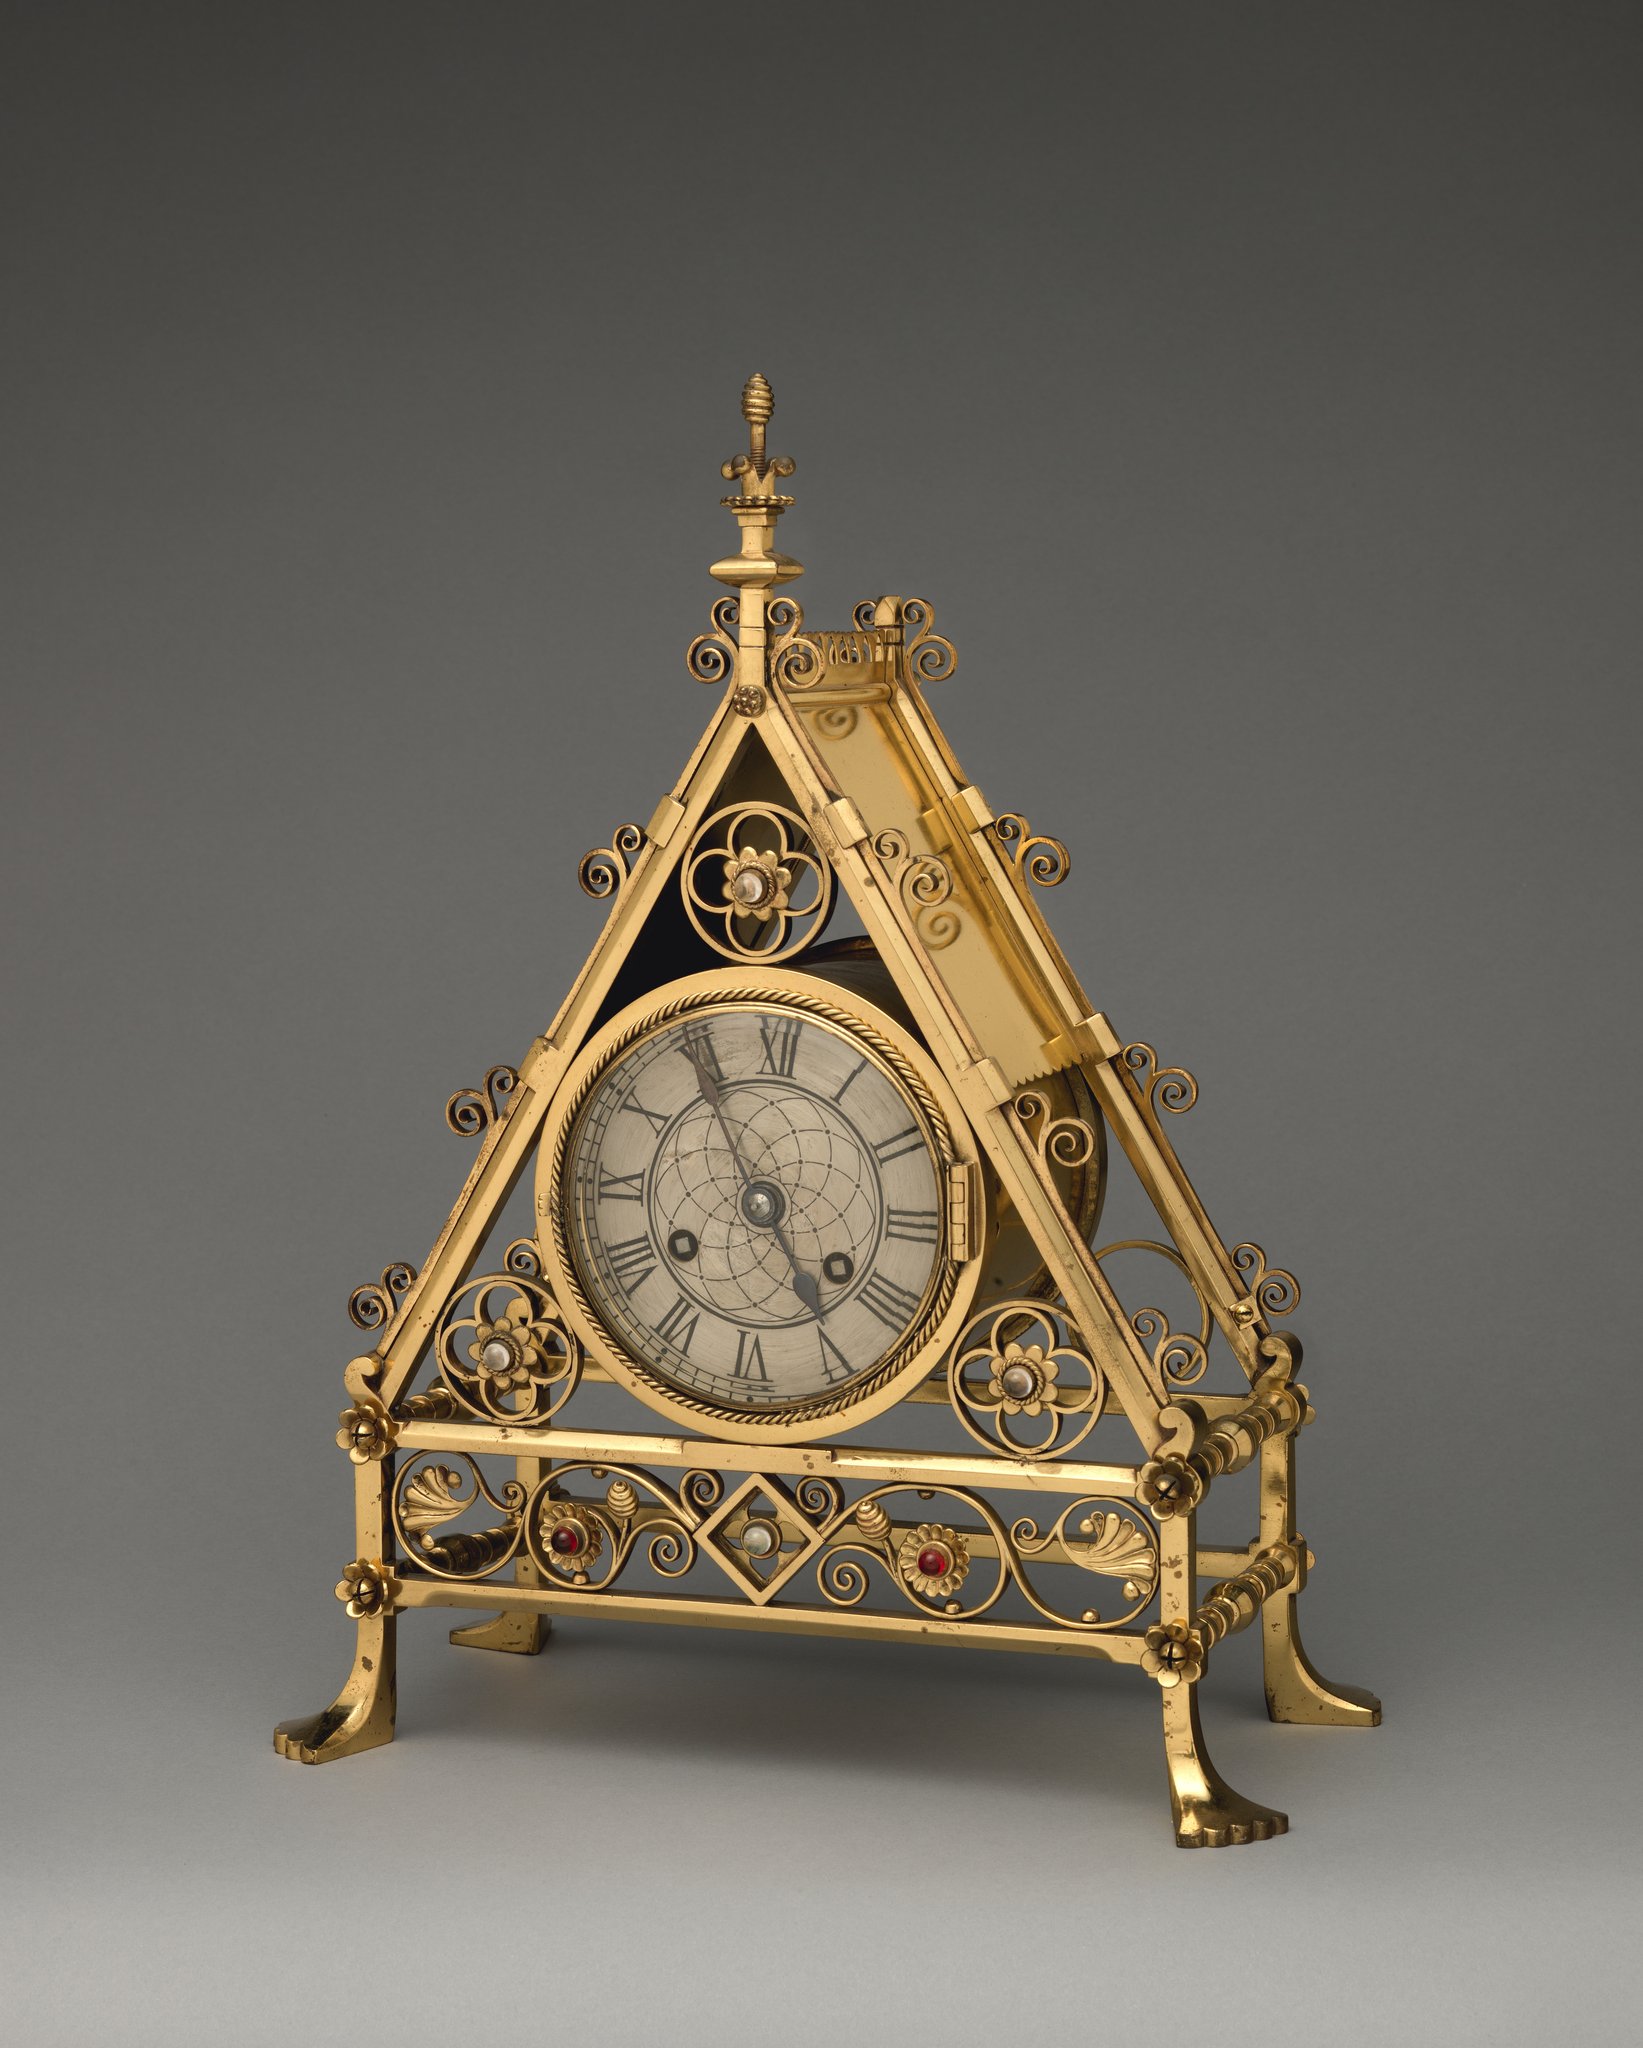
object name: clock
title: Mantel clock frame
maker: bruce j. talbert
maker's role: designer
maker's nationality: british, scottish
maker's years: 1838-1881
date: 1870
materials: brass, quartz